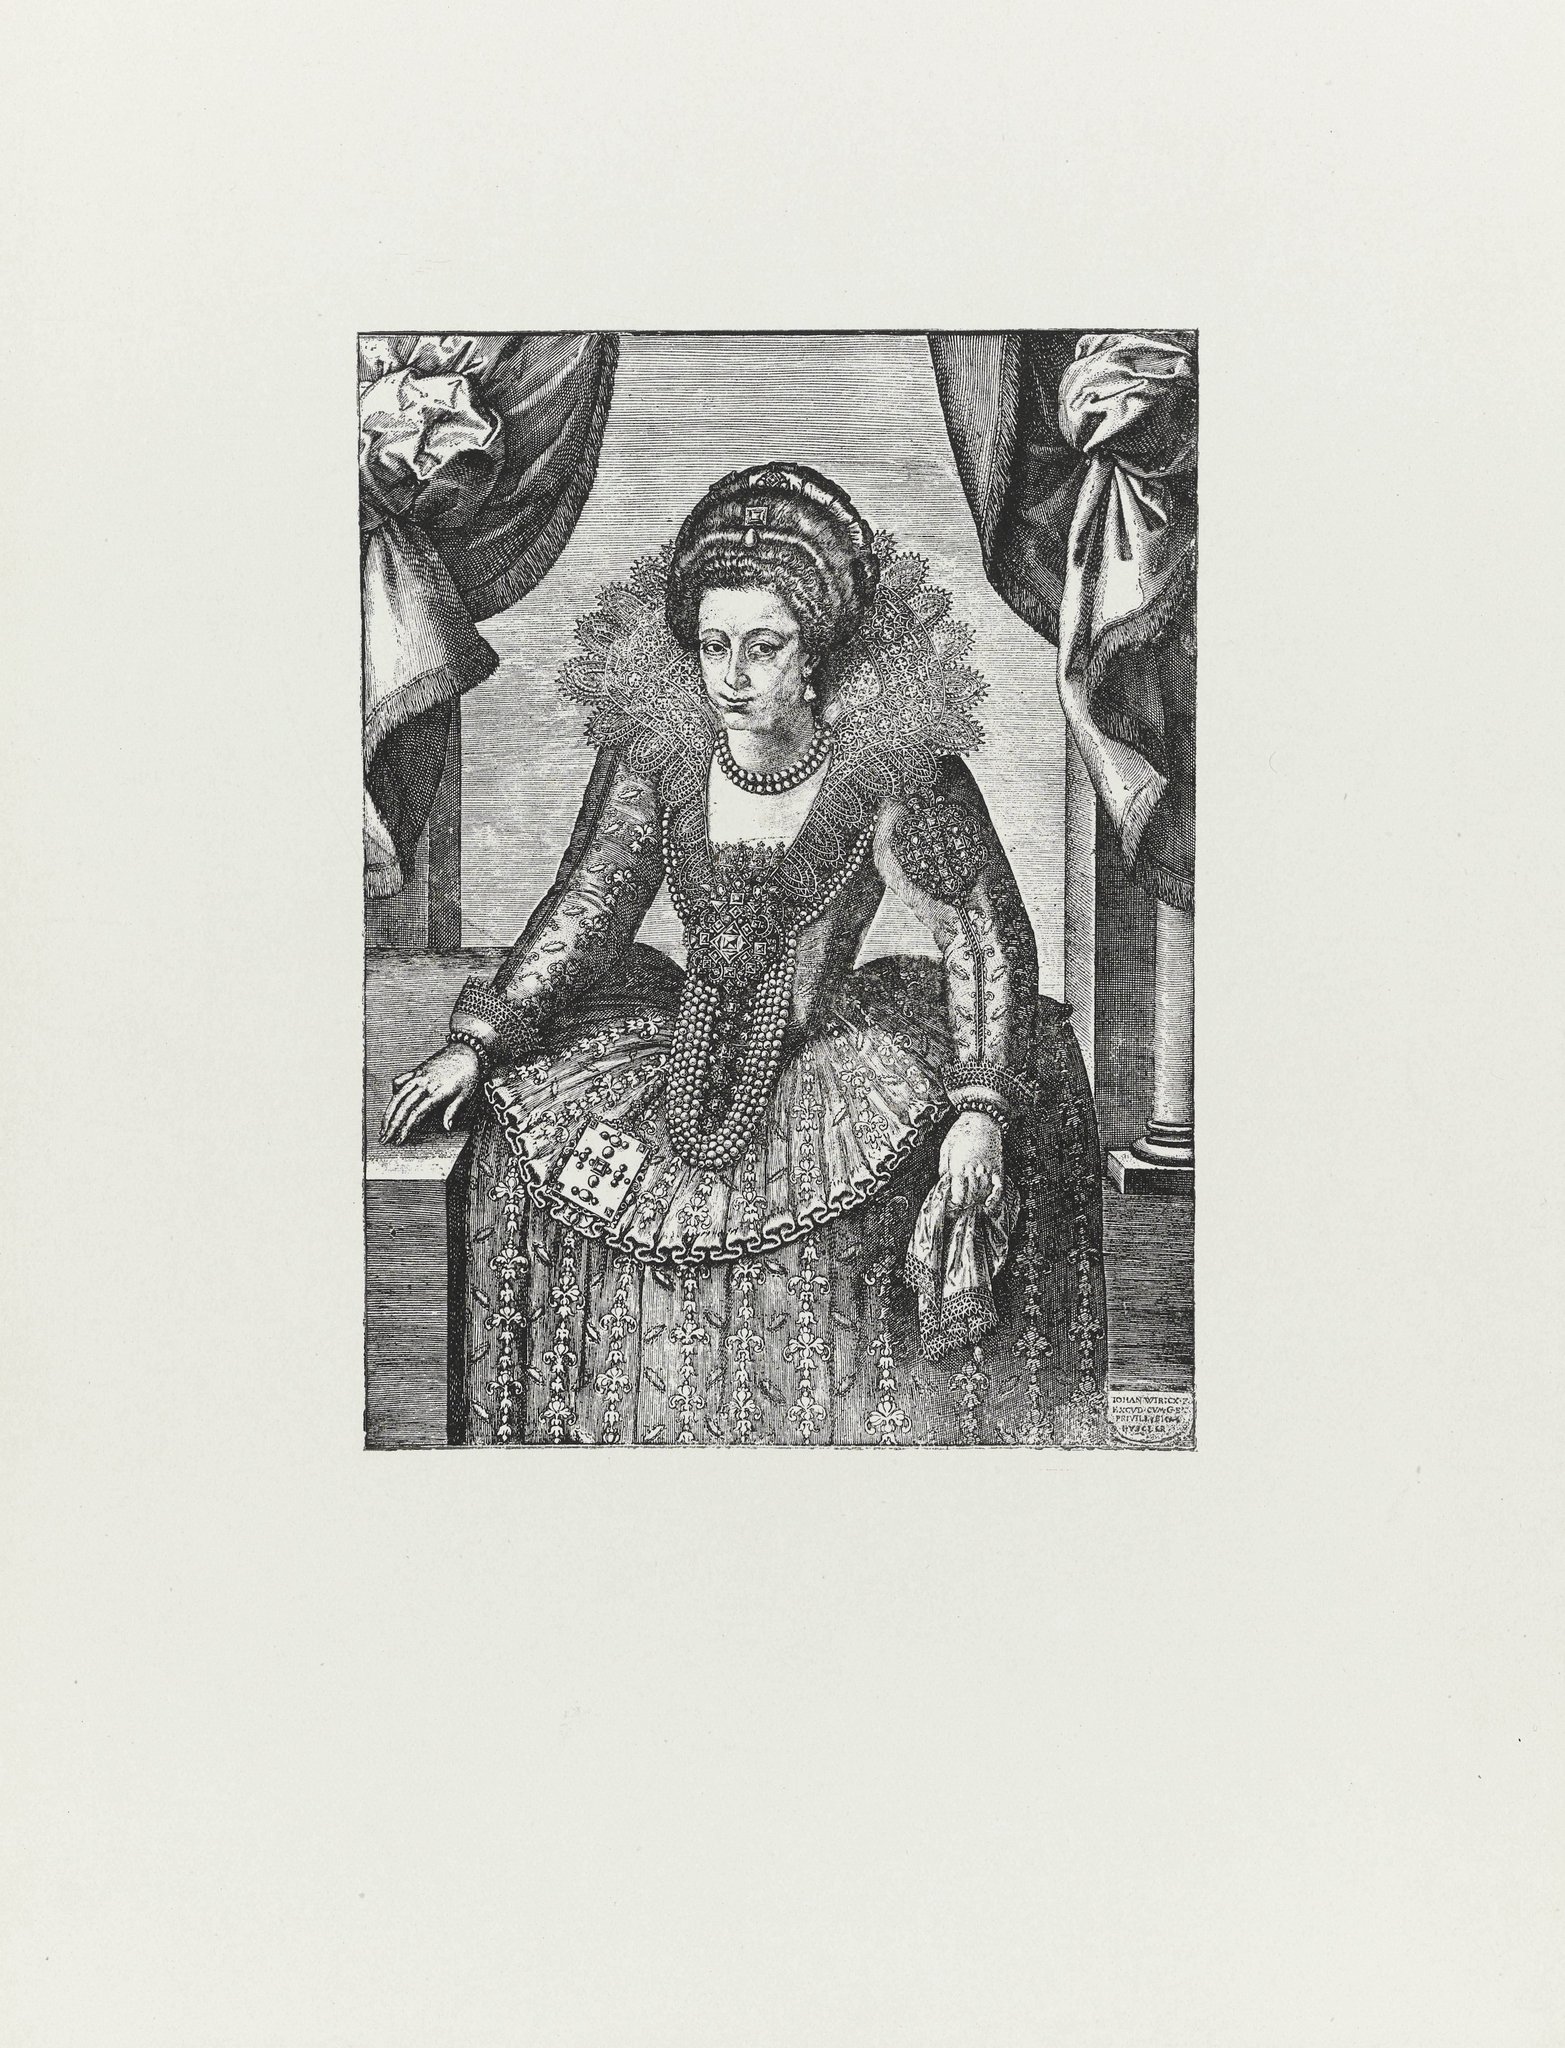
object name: photomechanical print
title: Portret van Eleonora van Bourbon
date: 1850-1949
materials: paper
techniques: autotype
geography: low countries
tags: éléonore de bourbon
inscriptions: collector's mark: Lugt 2228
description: Portret van Eleonora. In haar linkerhand een zakdoek.